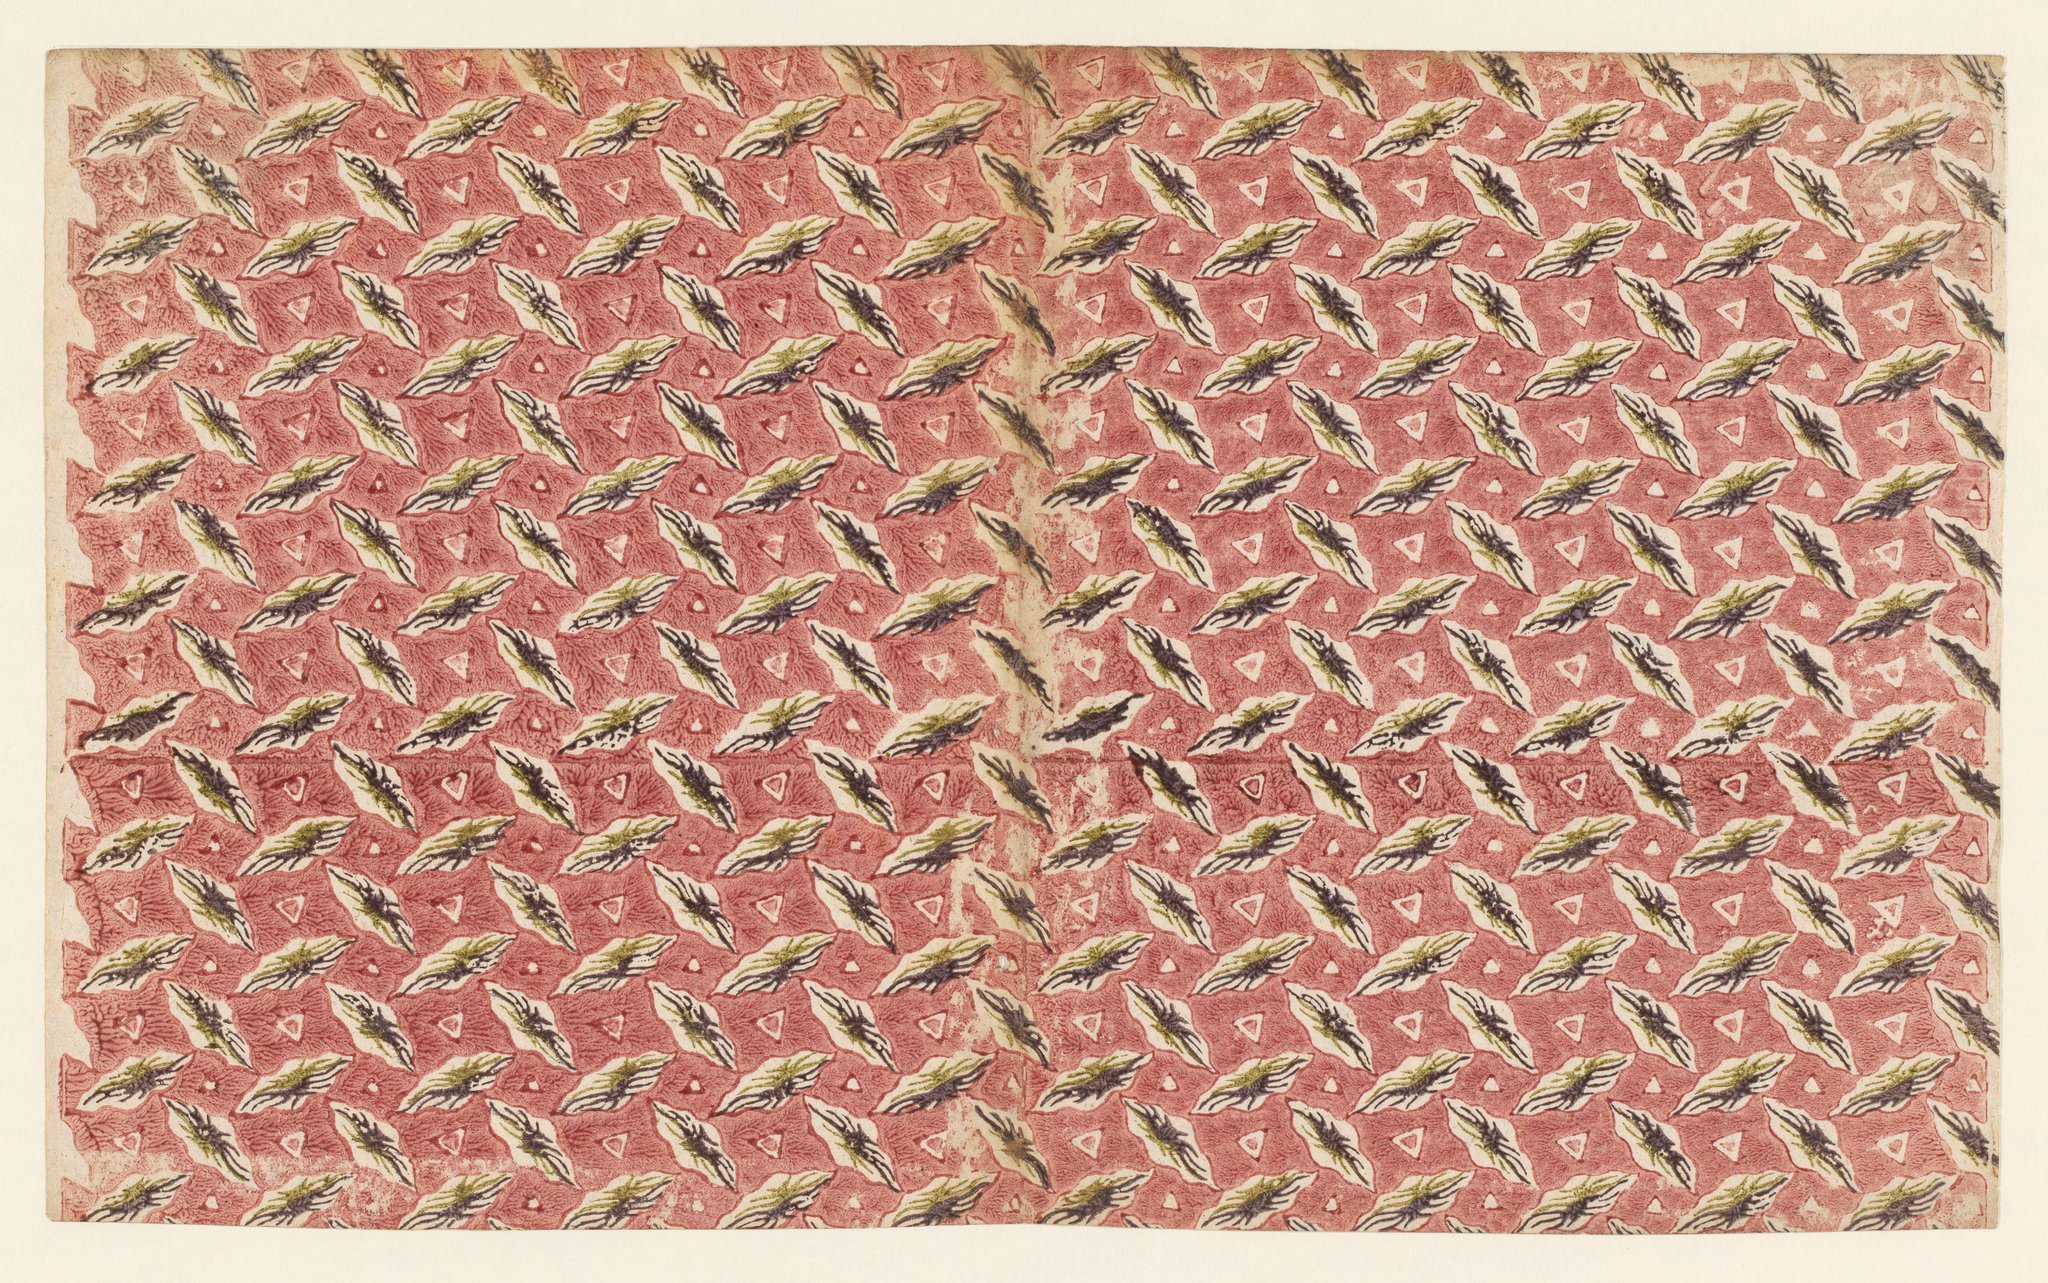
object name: printed paper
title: Blad met alternerend strooipatroon van fantasiemotief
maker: Anonymous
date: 1700-1850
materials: lacquer, paper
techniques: printing block, lacquer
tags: fantasy ornament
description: Blad met alternerend strooipatroon van fantasiemotief en driehoekje. Gebruikt als omslag.